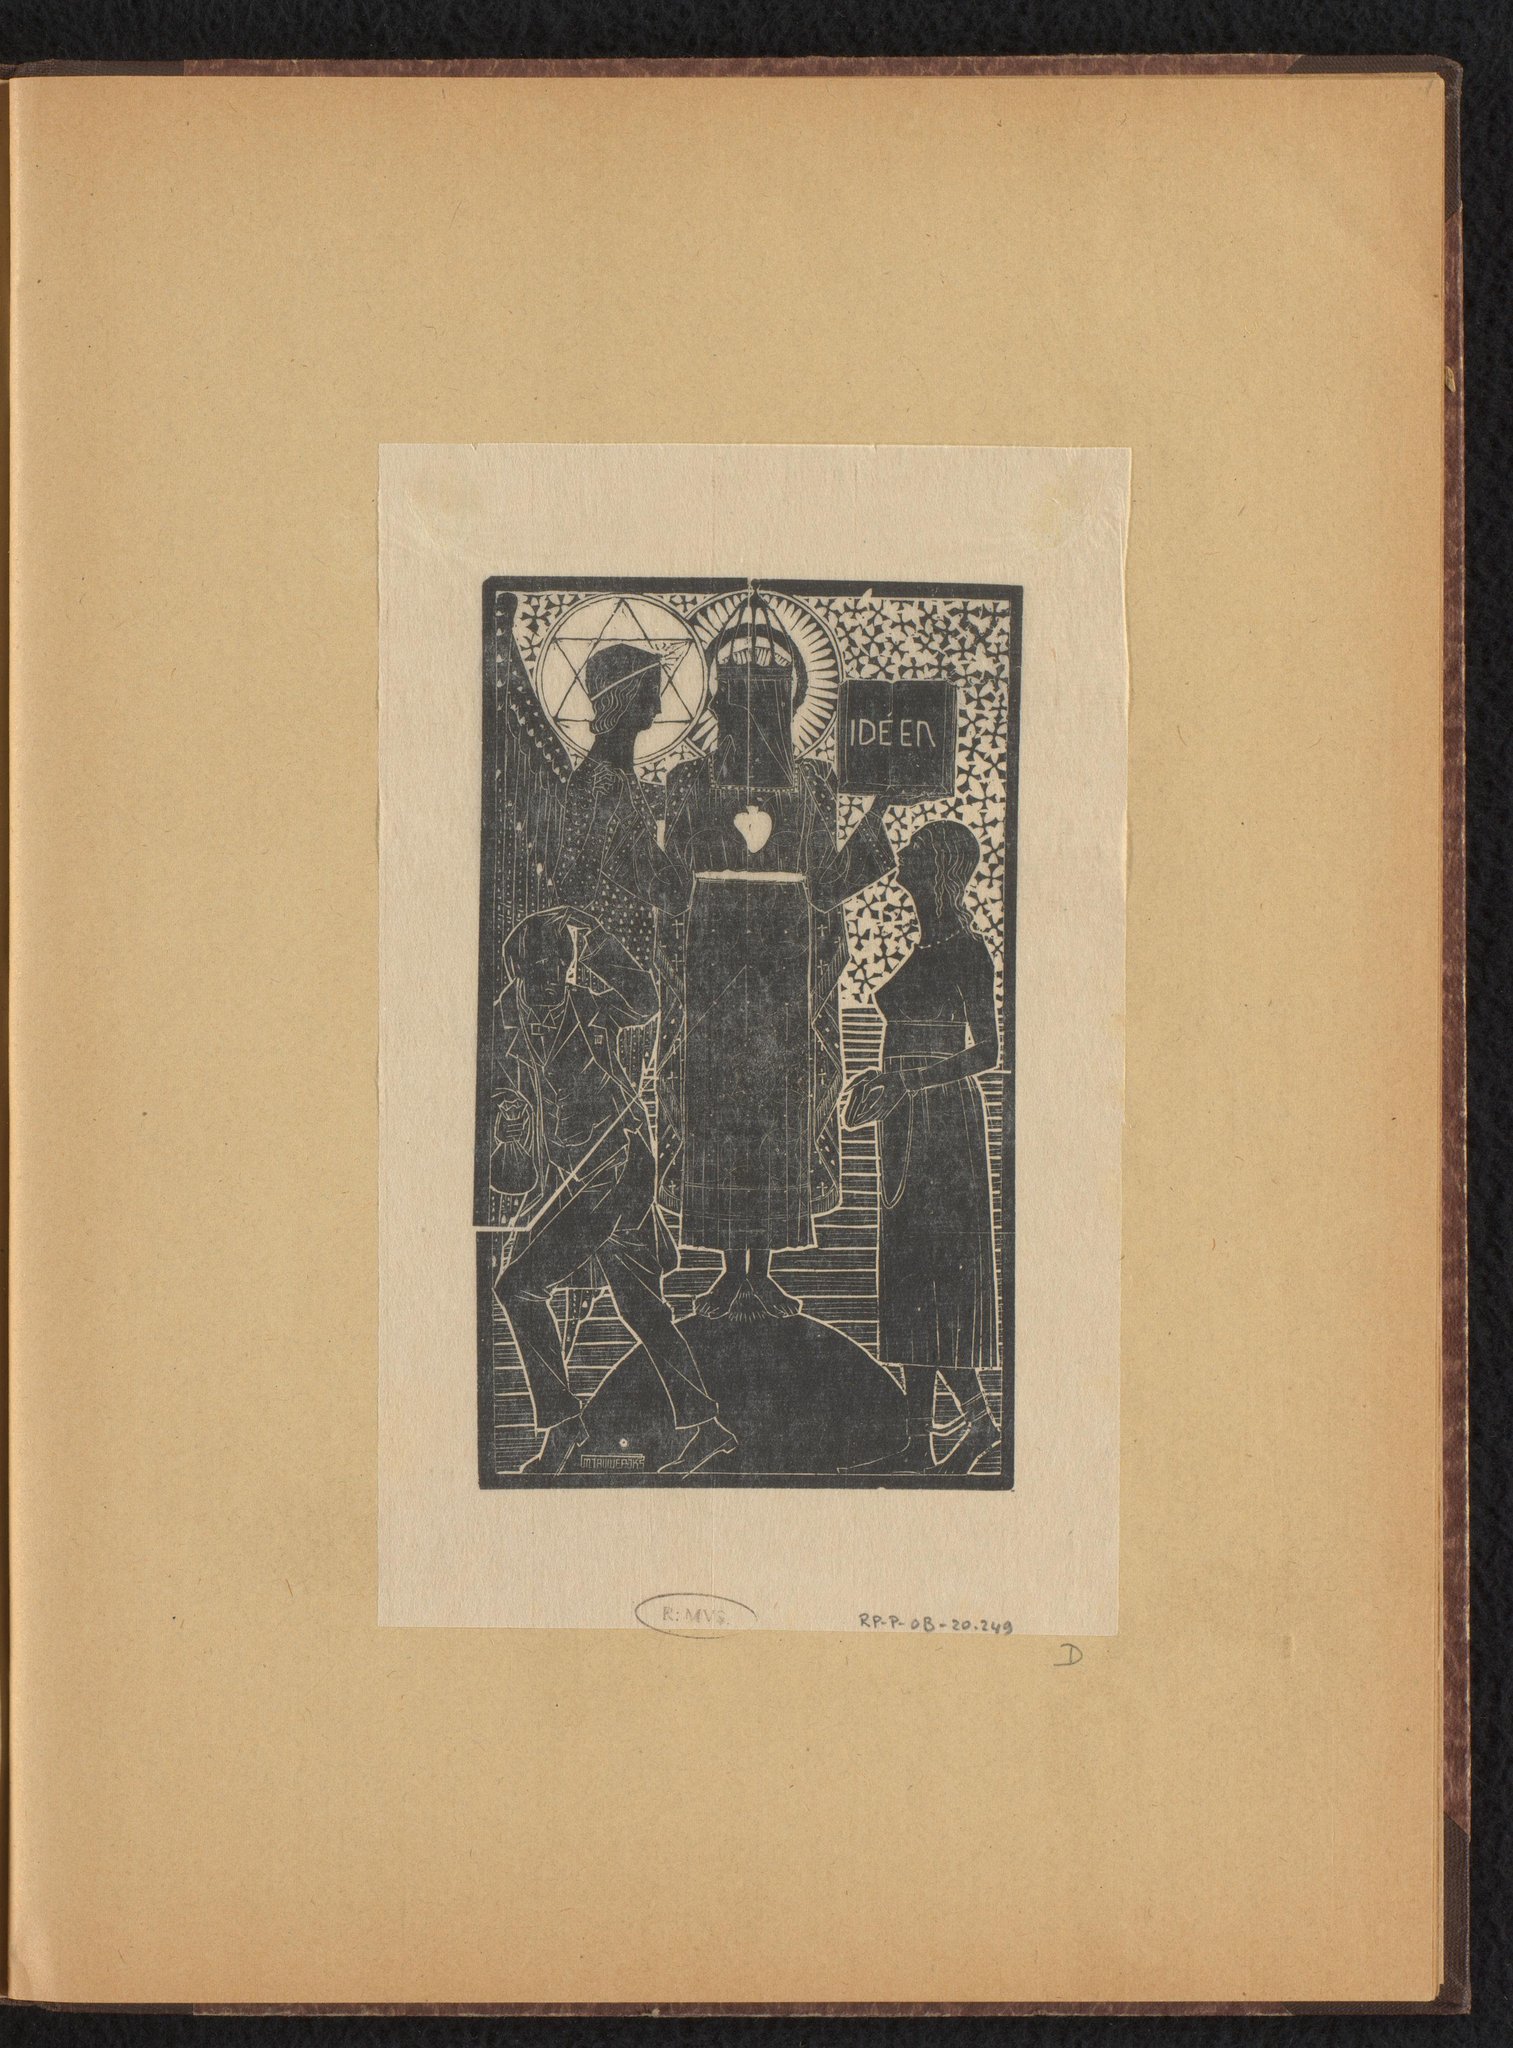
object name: print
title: Vier figuren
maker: mathieu lauweriks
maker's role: designer, draughtsman, print maker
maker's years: 1864-1932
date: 1895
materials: paper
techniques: woodcut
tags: standing figure, book - mm - book open, (person) in fetters, not imprisoned, thief, heart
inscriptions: collector's mark: Lugt 2228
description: Prent ter gelegenheid van een herdenking van de sterfdag van Multatuli. De prent is gebruikt als illustratie bij het gedicht 'Eduard Douwes Dekker' in: Licht en waarheid. Orgaan van de vereeniging 'Wie Denkt Overwint', 16 februari 1895. De prent is ook gebruikt voor: Wendingen. Maandblad voor bouwen en sieren van "Architectura et Amicitia", 1919, 7/8, p. 9.